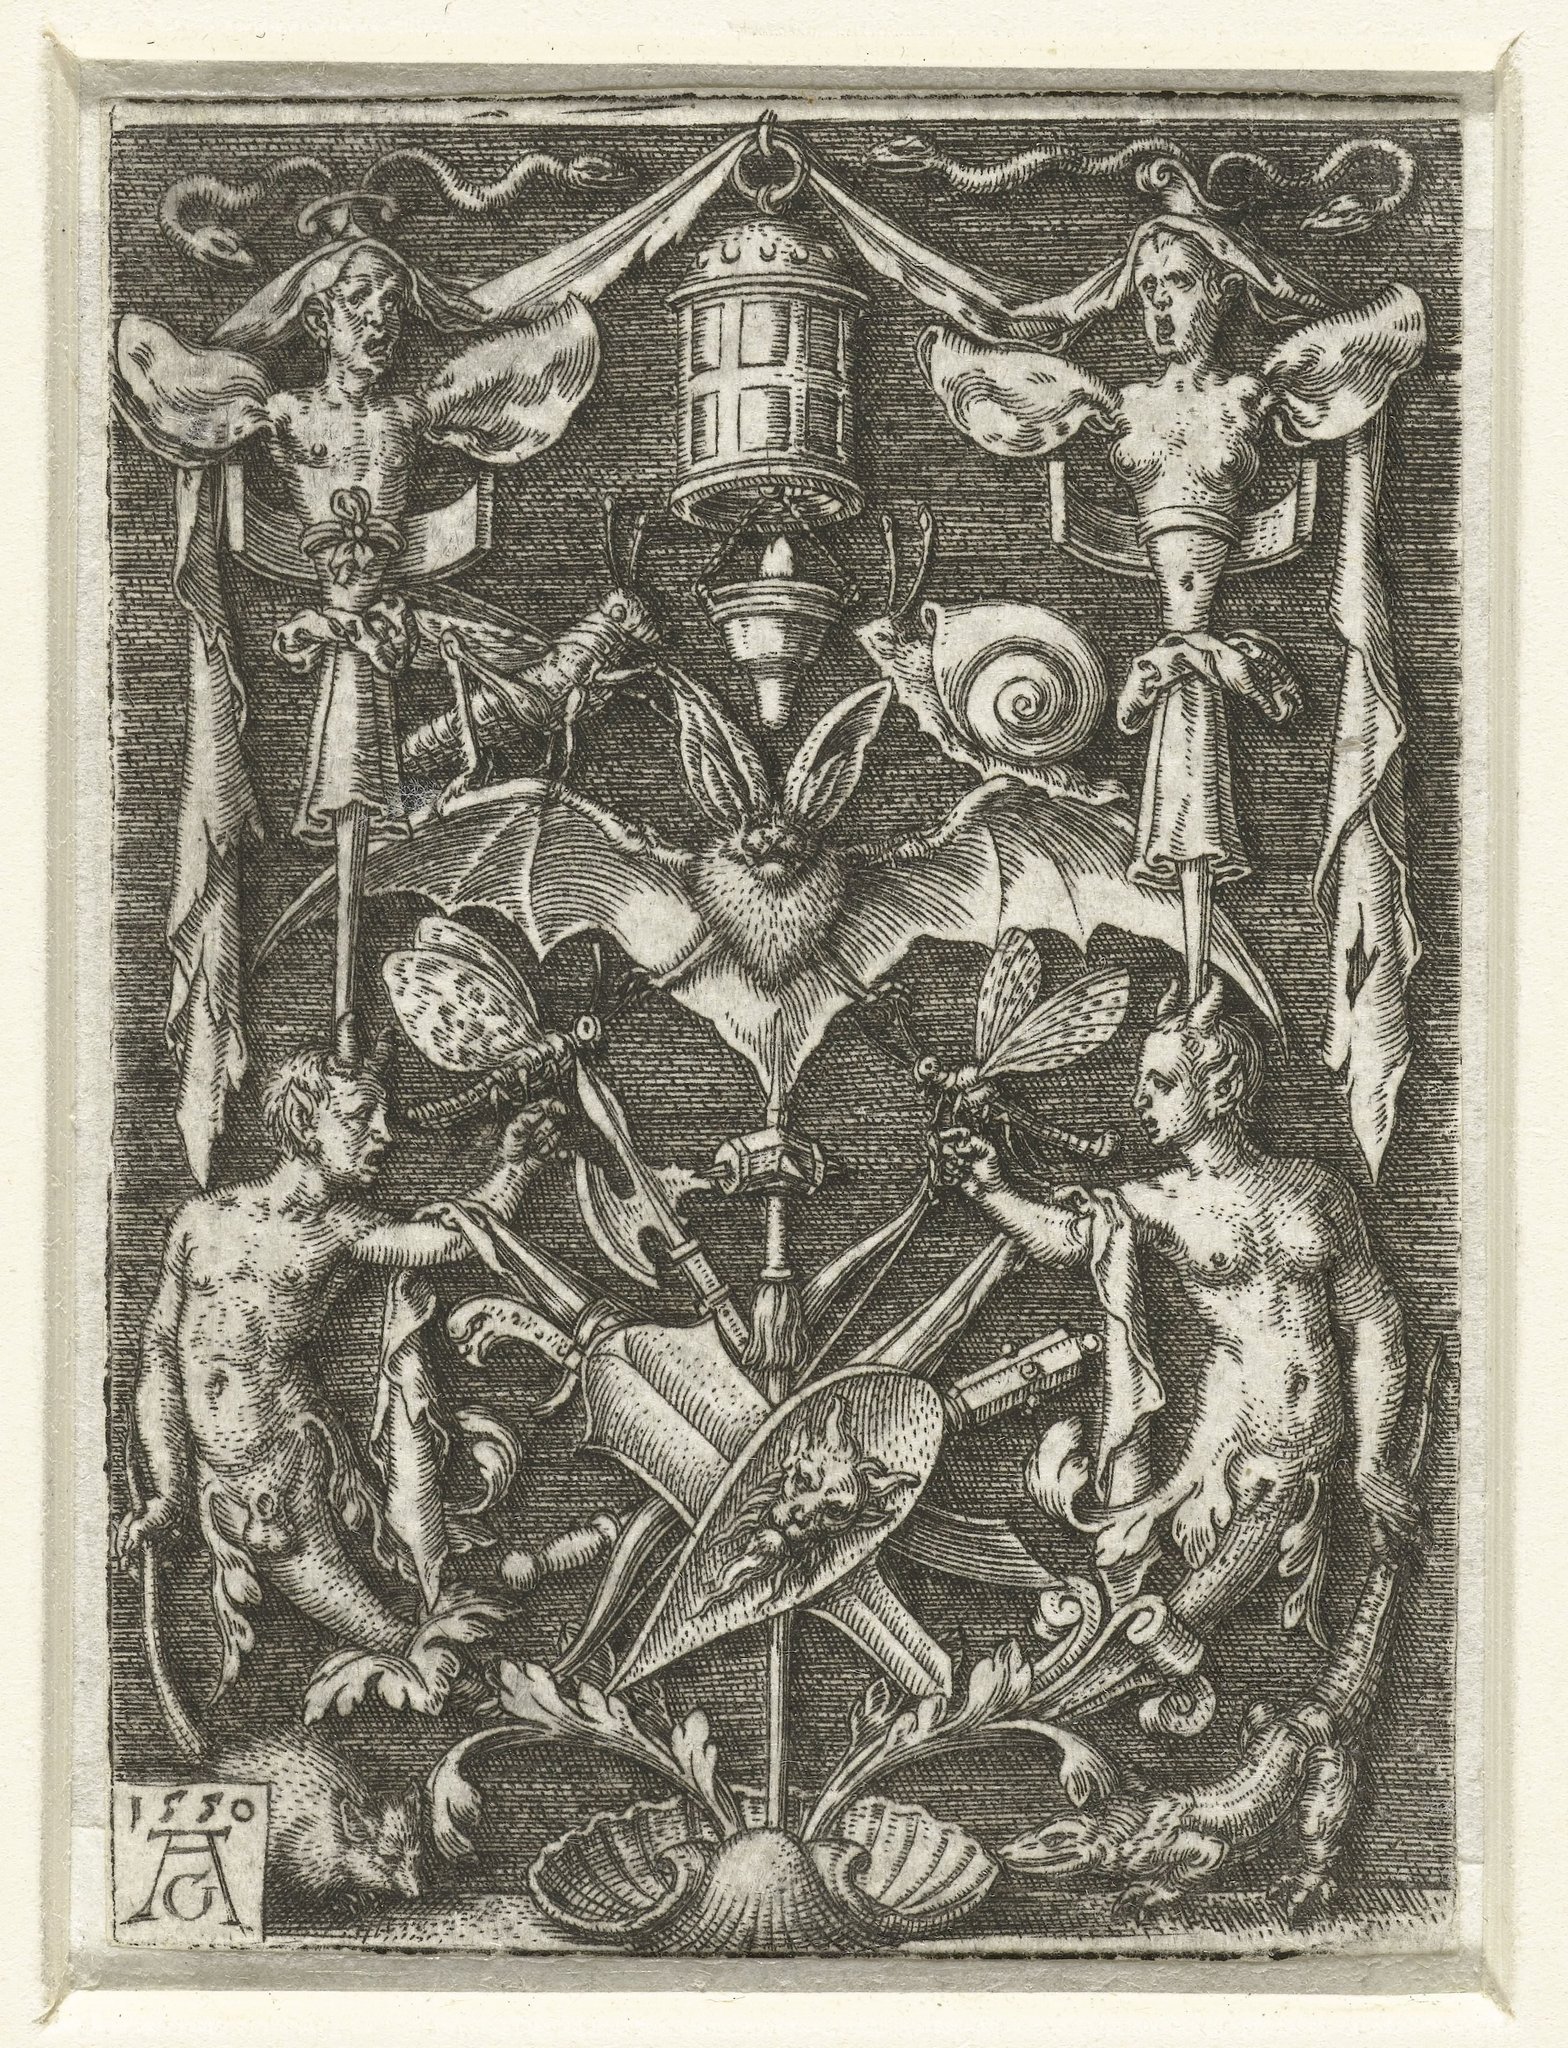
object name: print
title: Vlakdecoratie met grotesken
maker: heinrich aldegrever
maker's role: draughtsman, print maker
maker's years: 1502-1561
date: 1550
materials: paper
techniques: engraving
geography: germany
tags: ornaments ~ art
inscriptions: number: ‘23’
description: Vlakdecoratie met in het midden een vleermuis met een slak en insekt op de vleugels, daaronder een wapentrofee die in een schelp staat. Uit de schelp komen ook twee bladranken, uitlopend in een mannelijke en vrouwelijke sater, die elk een gevleugelde herme op hun hoofd hebben staan.